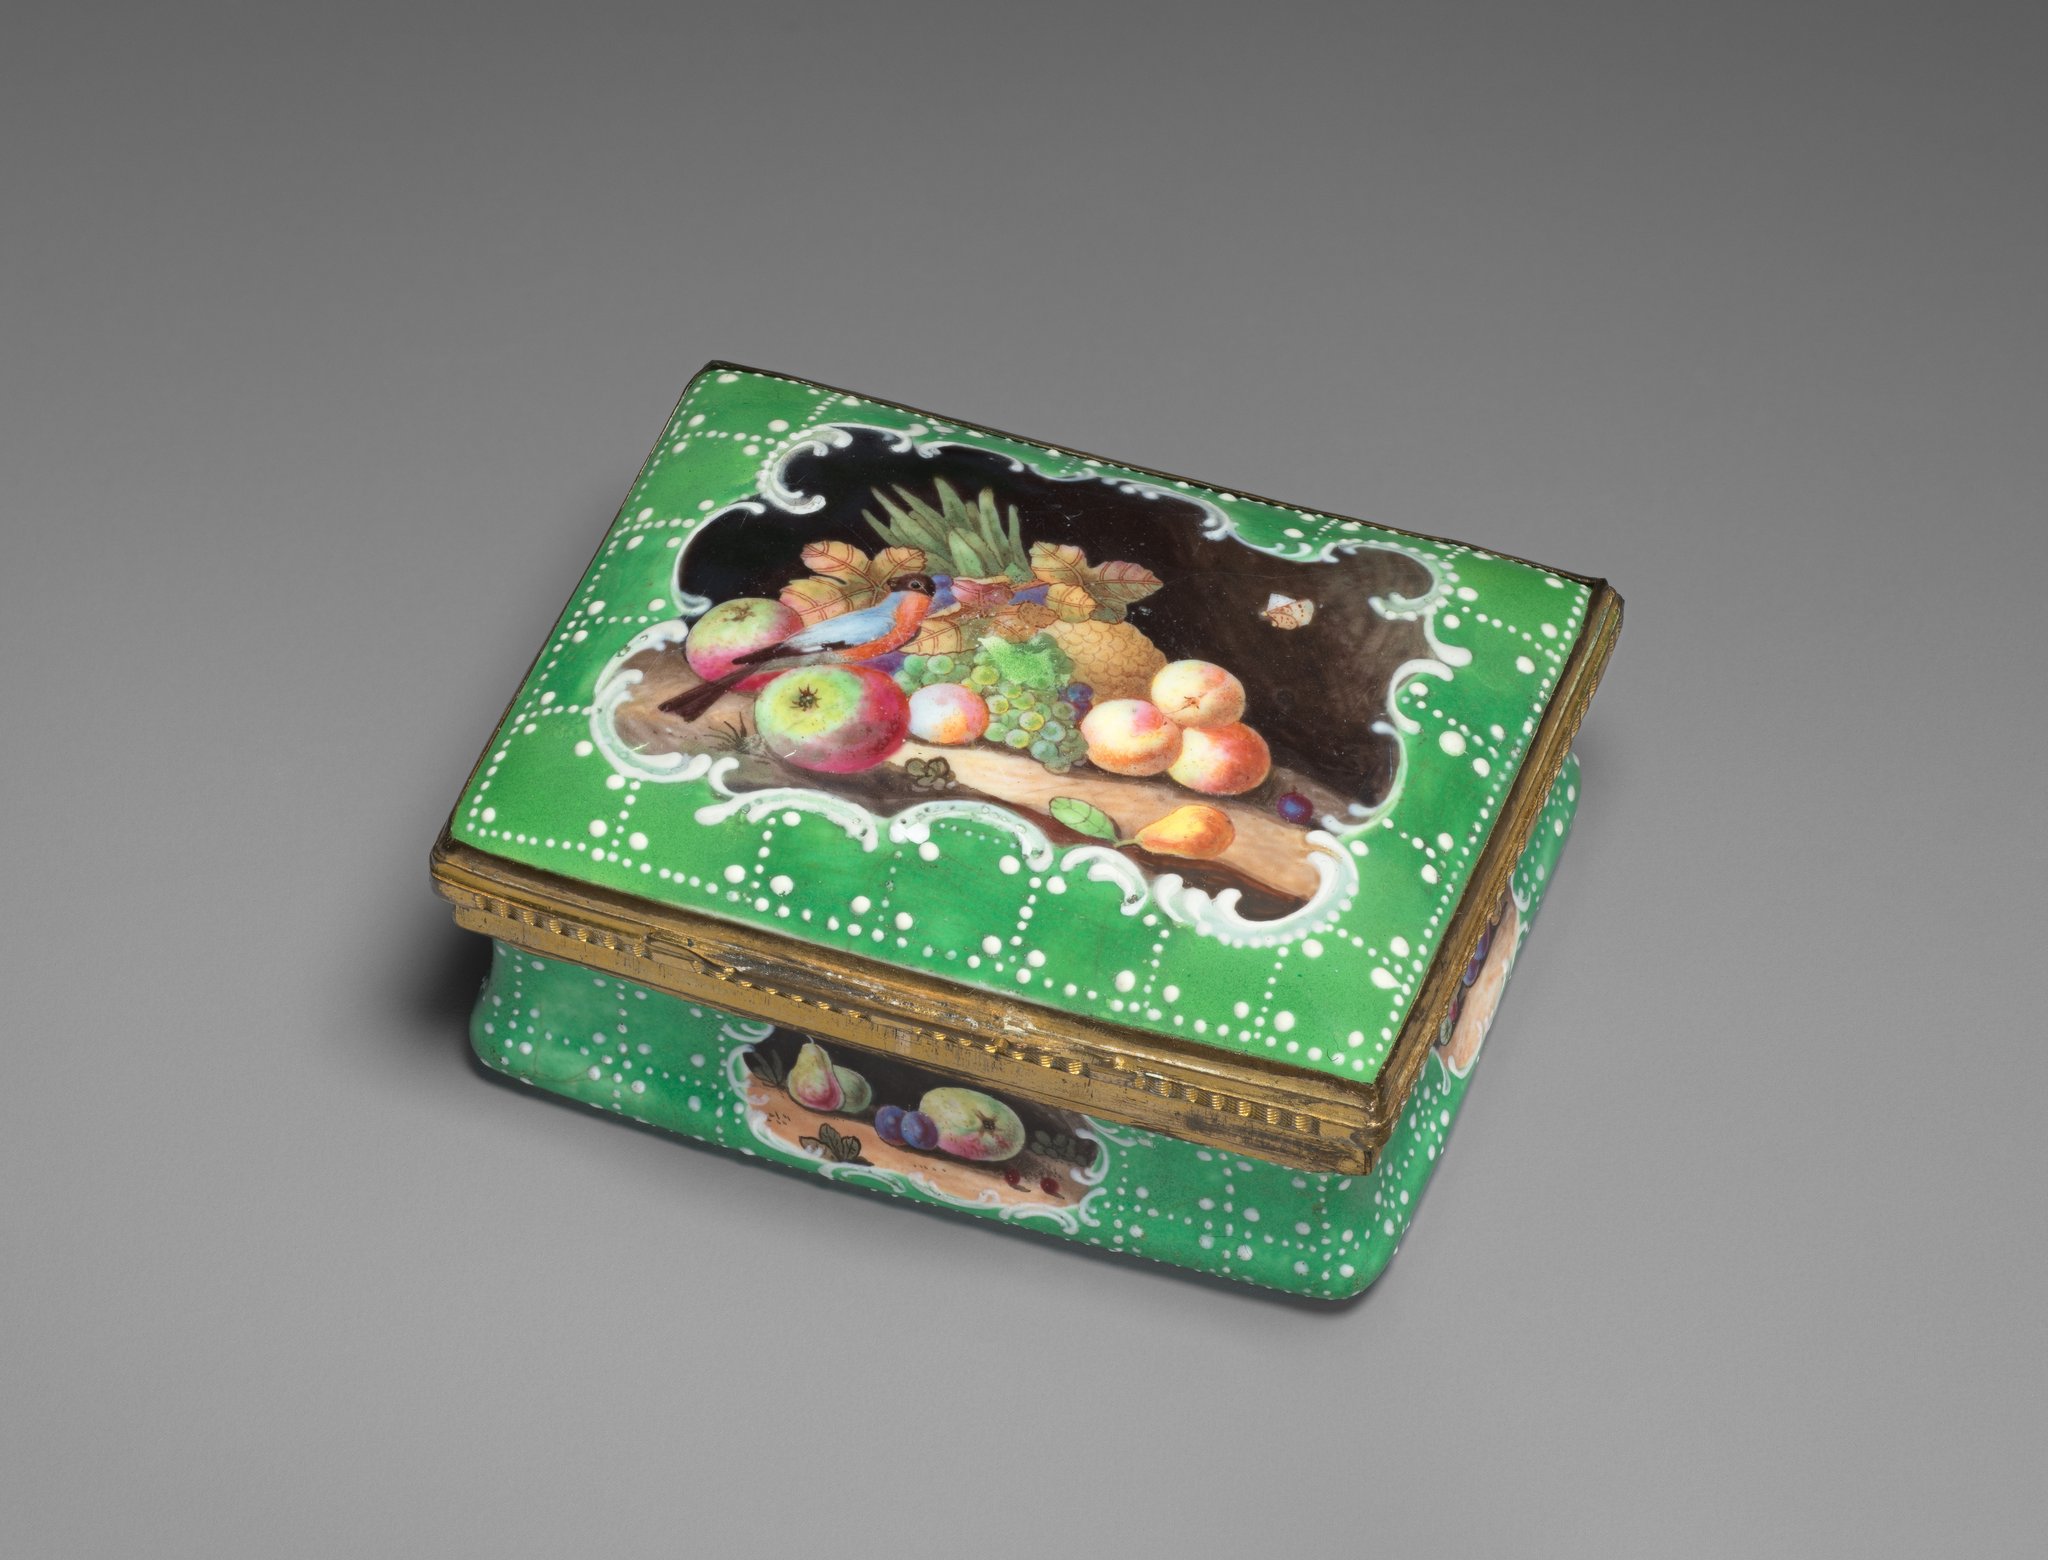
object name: snuffbox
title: Snuffbox with still life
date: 1765-1770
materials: copper, enamel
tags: birds,fruit